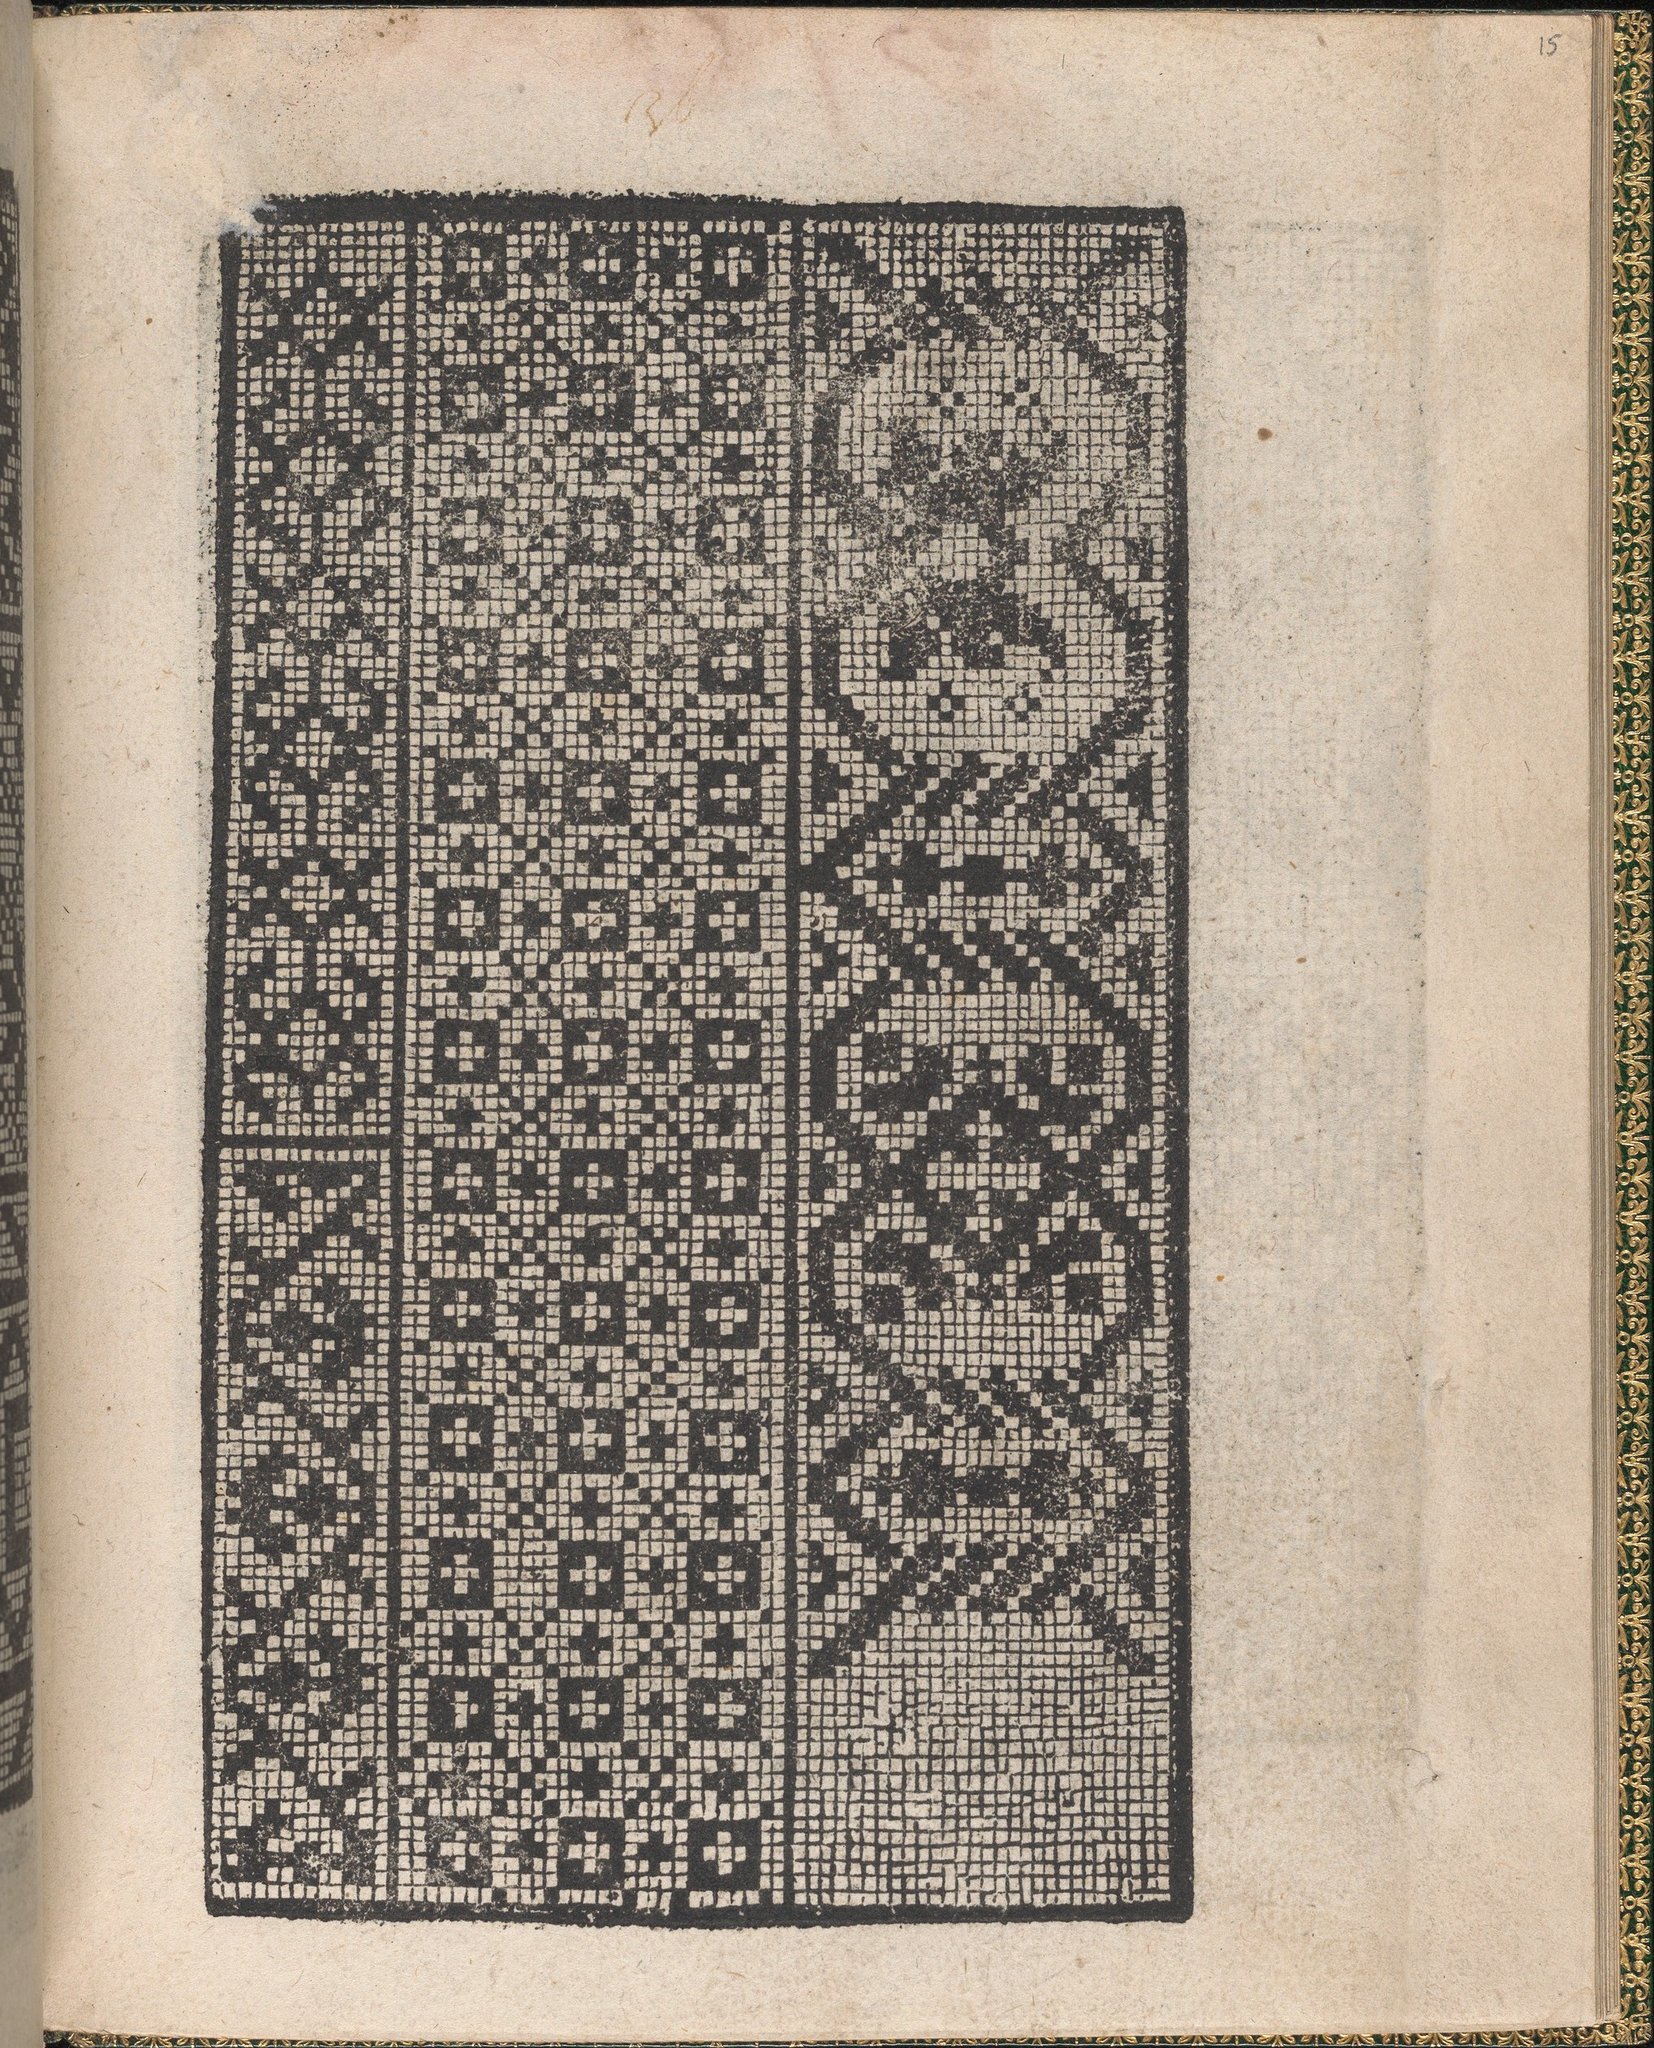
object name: book print ornament architecture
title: Ornamento delle belle & virtuose donne, page 15 (recto)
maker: matteo pagano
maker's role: publisher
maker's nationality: italian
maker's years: 1515-1588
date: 1554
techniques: woodcut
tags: ornament